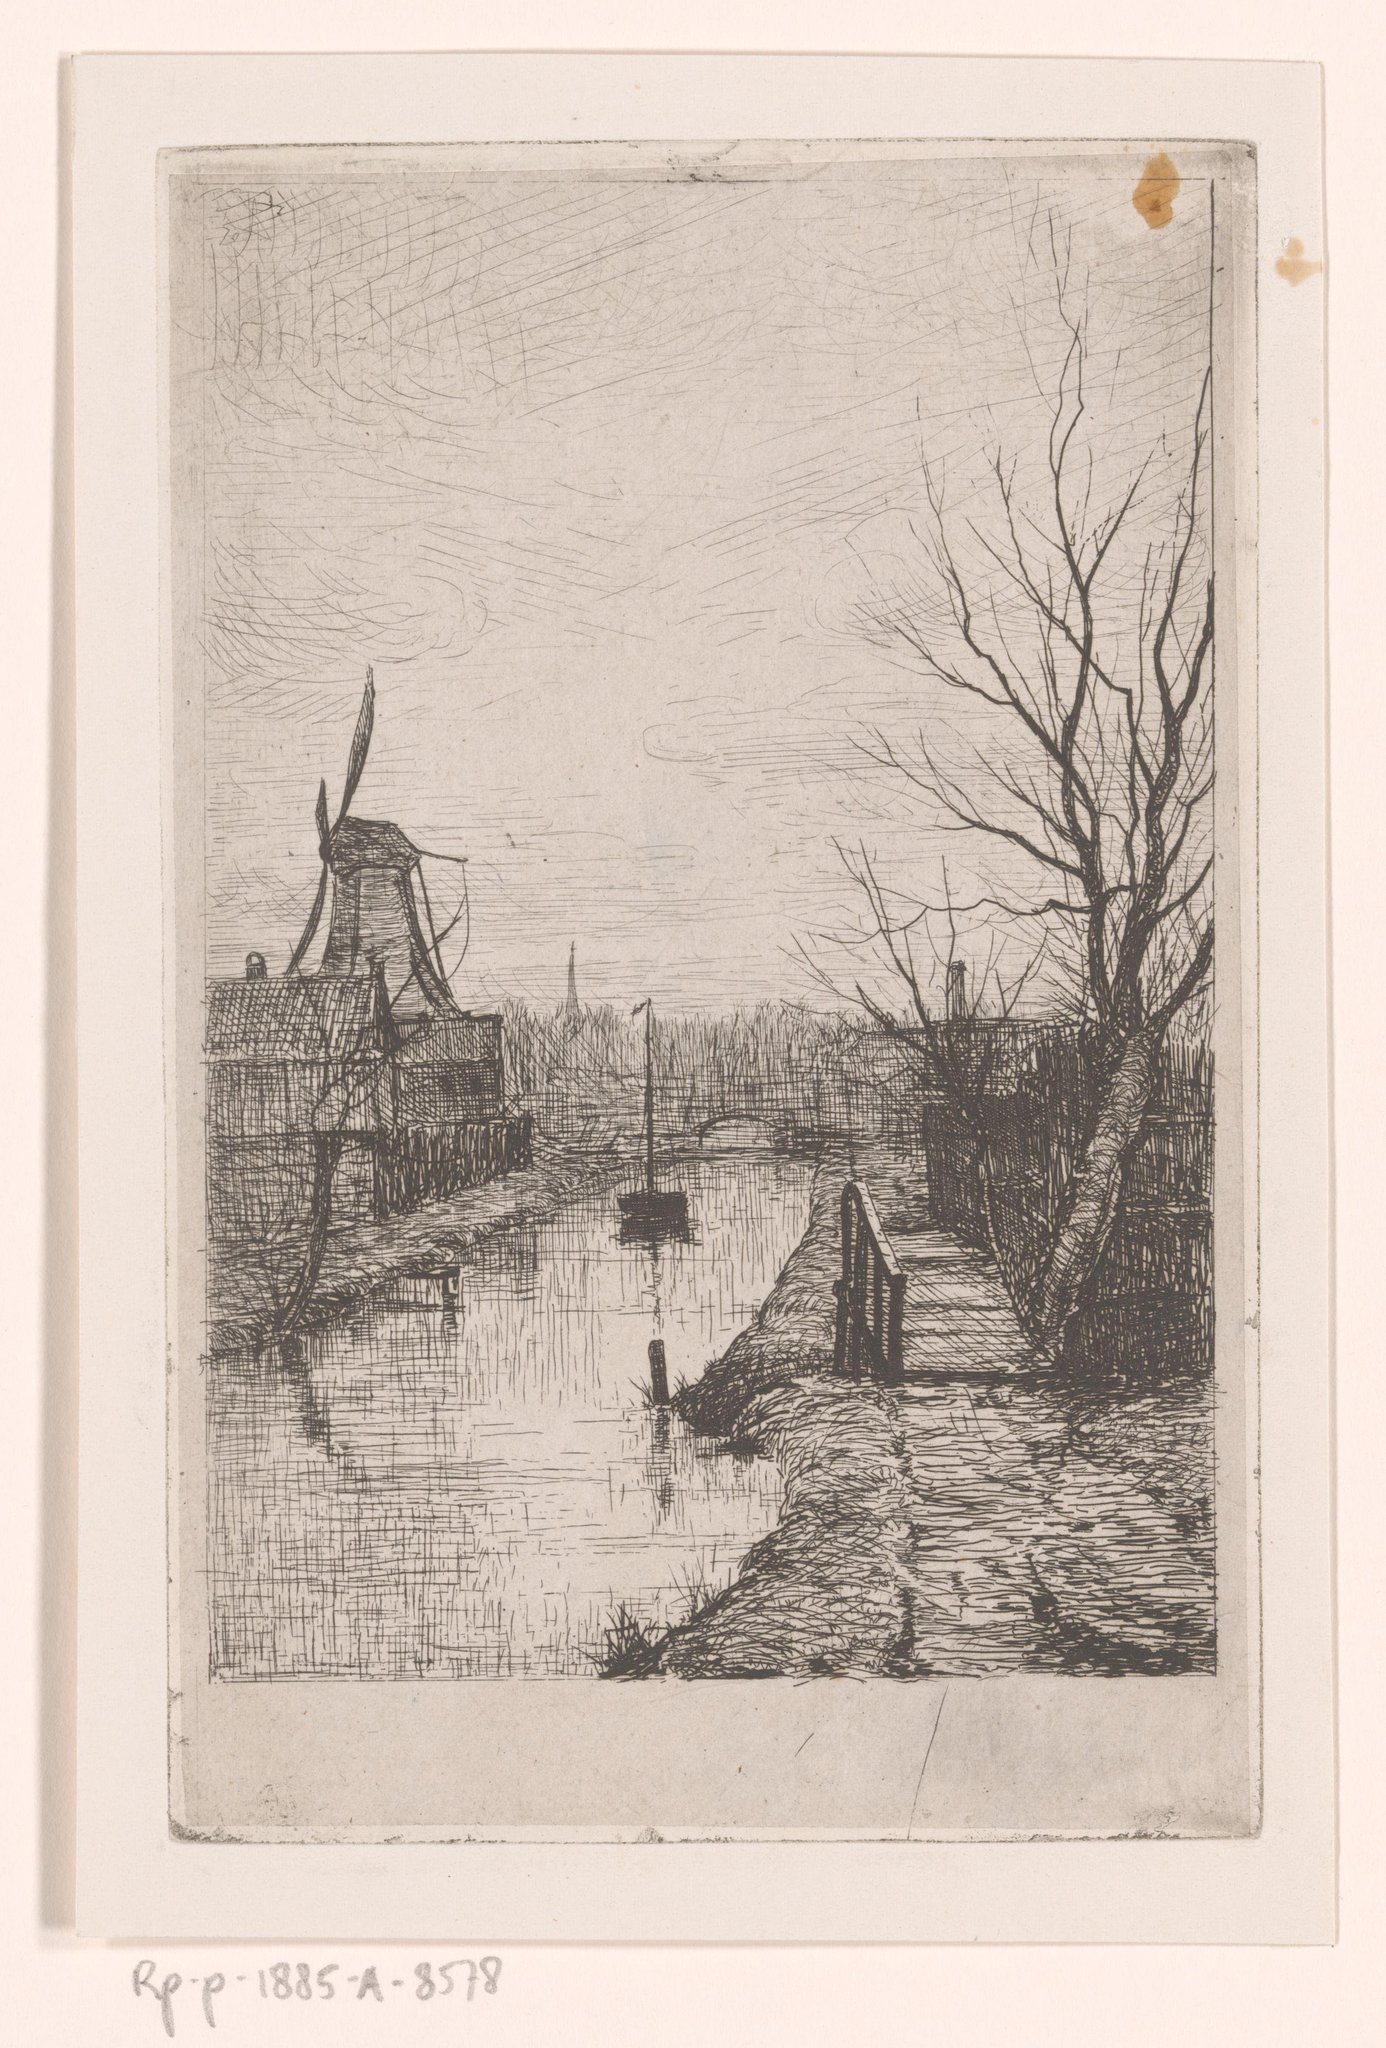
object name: print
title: Passerelle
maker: philip zilcken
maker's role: draughtsman, painter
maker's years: 1857-1930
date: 1879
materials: paper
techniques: etching, intaglio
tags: canal, windmill in landscape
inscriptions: collector's mark: Lugt 2228